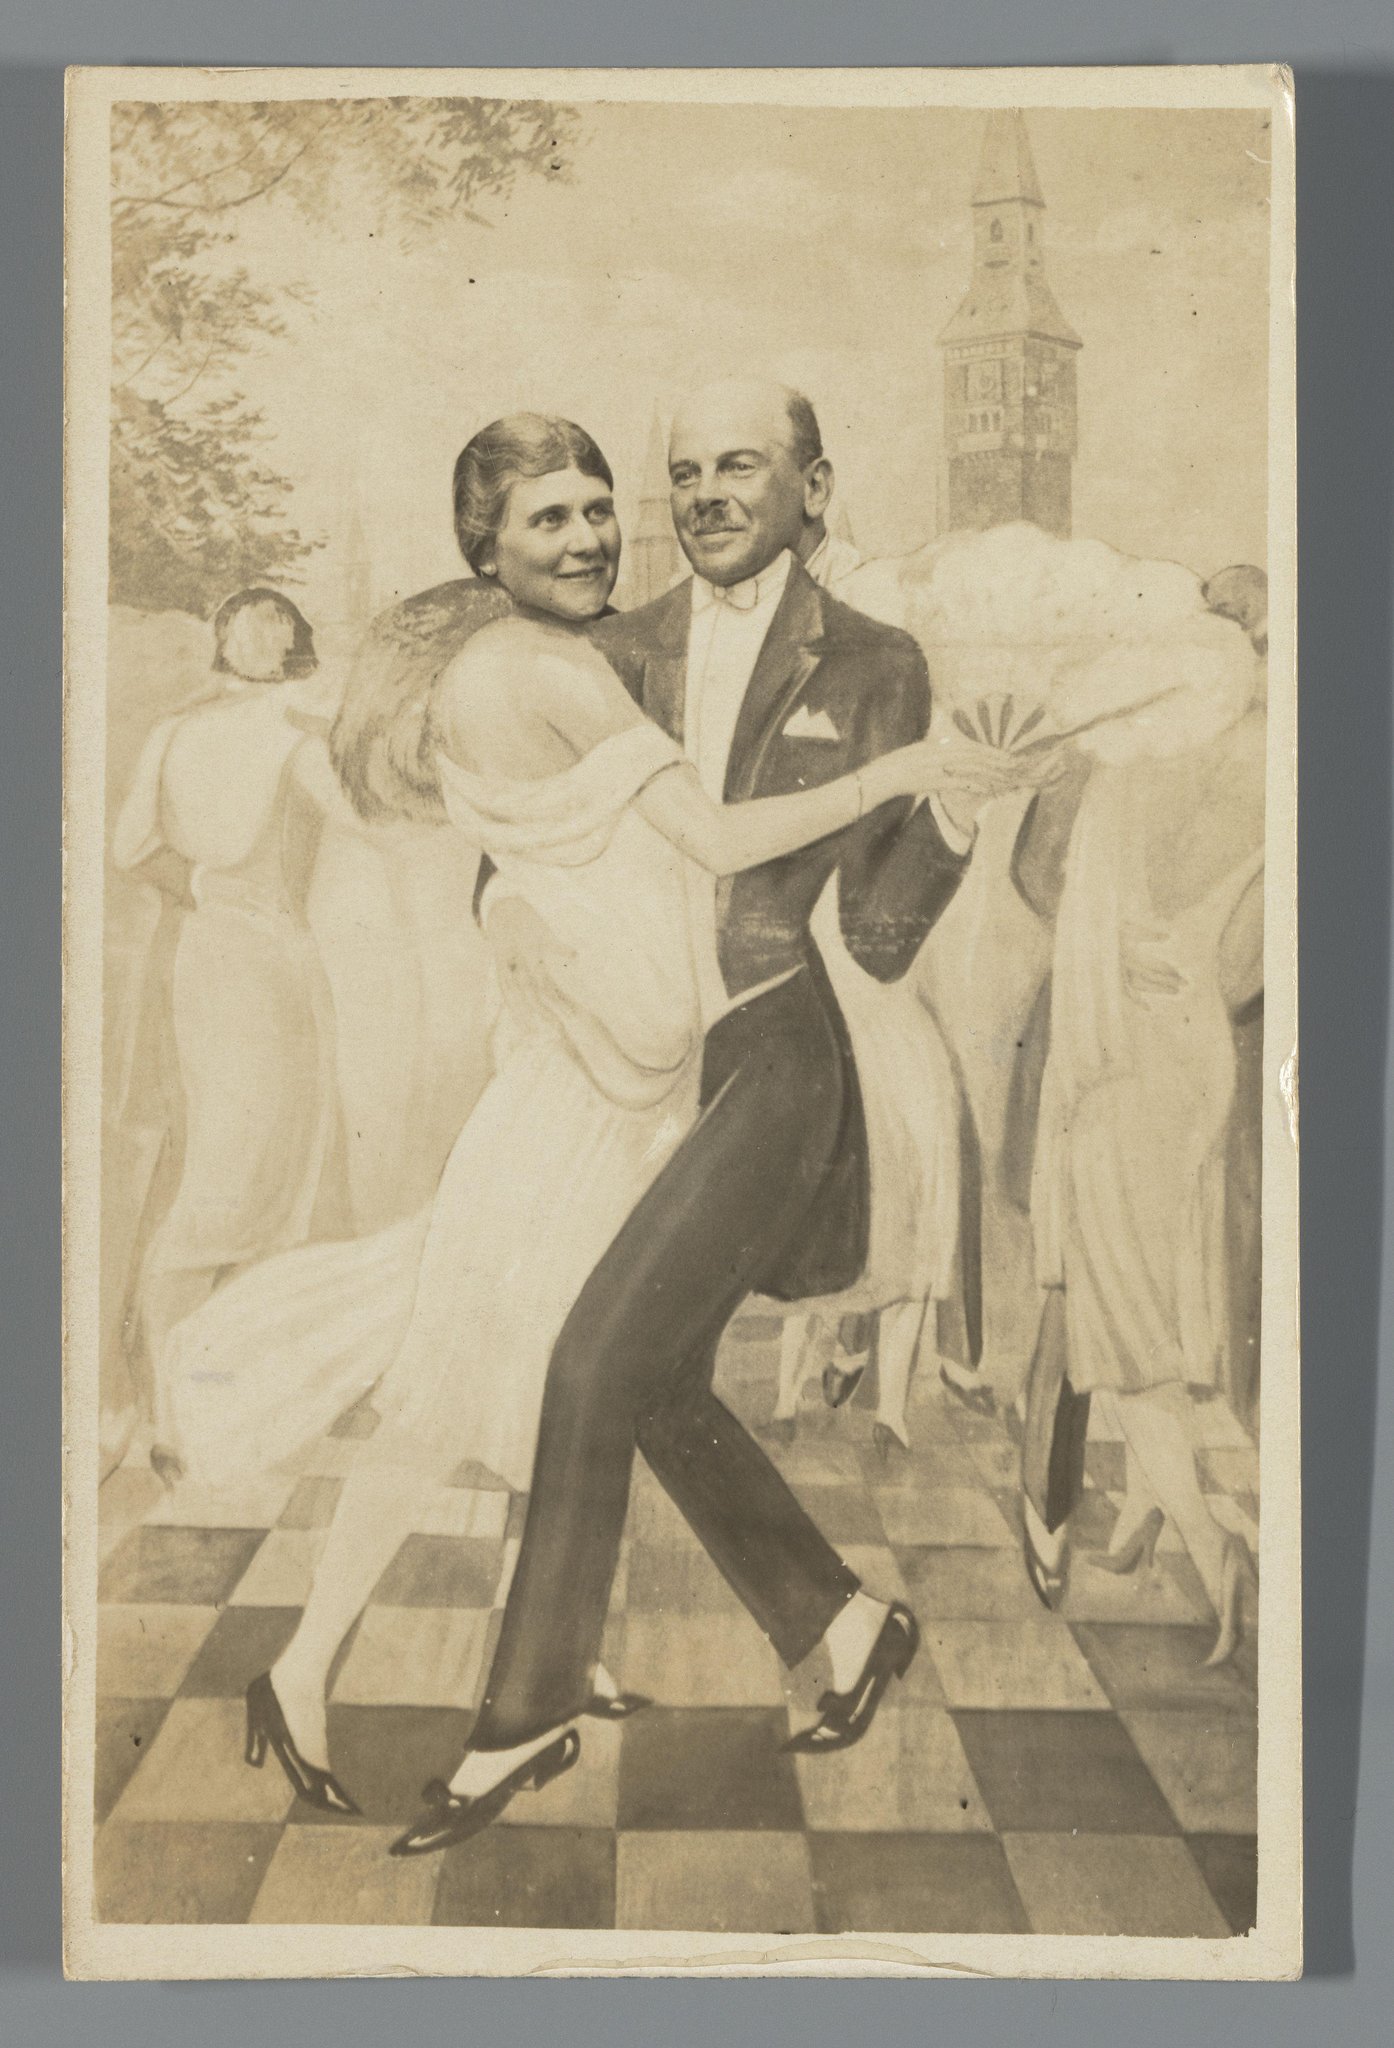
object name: photograph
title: Portret van Line en Hendrik Herman van den Berg in een geschilderd decor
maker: Anonymous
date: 1927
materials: photographic support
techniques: photography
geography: netherlands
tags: batavia, amsterdam, hendrik herman van den berg, caroline louise van den berg-van den berg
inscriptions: stamp, seal, stamp: ‘A 412’, inscription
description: De gezichten van de geportretteerden steken door een decor van een dansend paar.